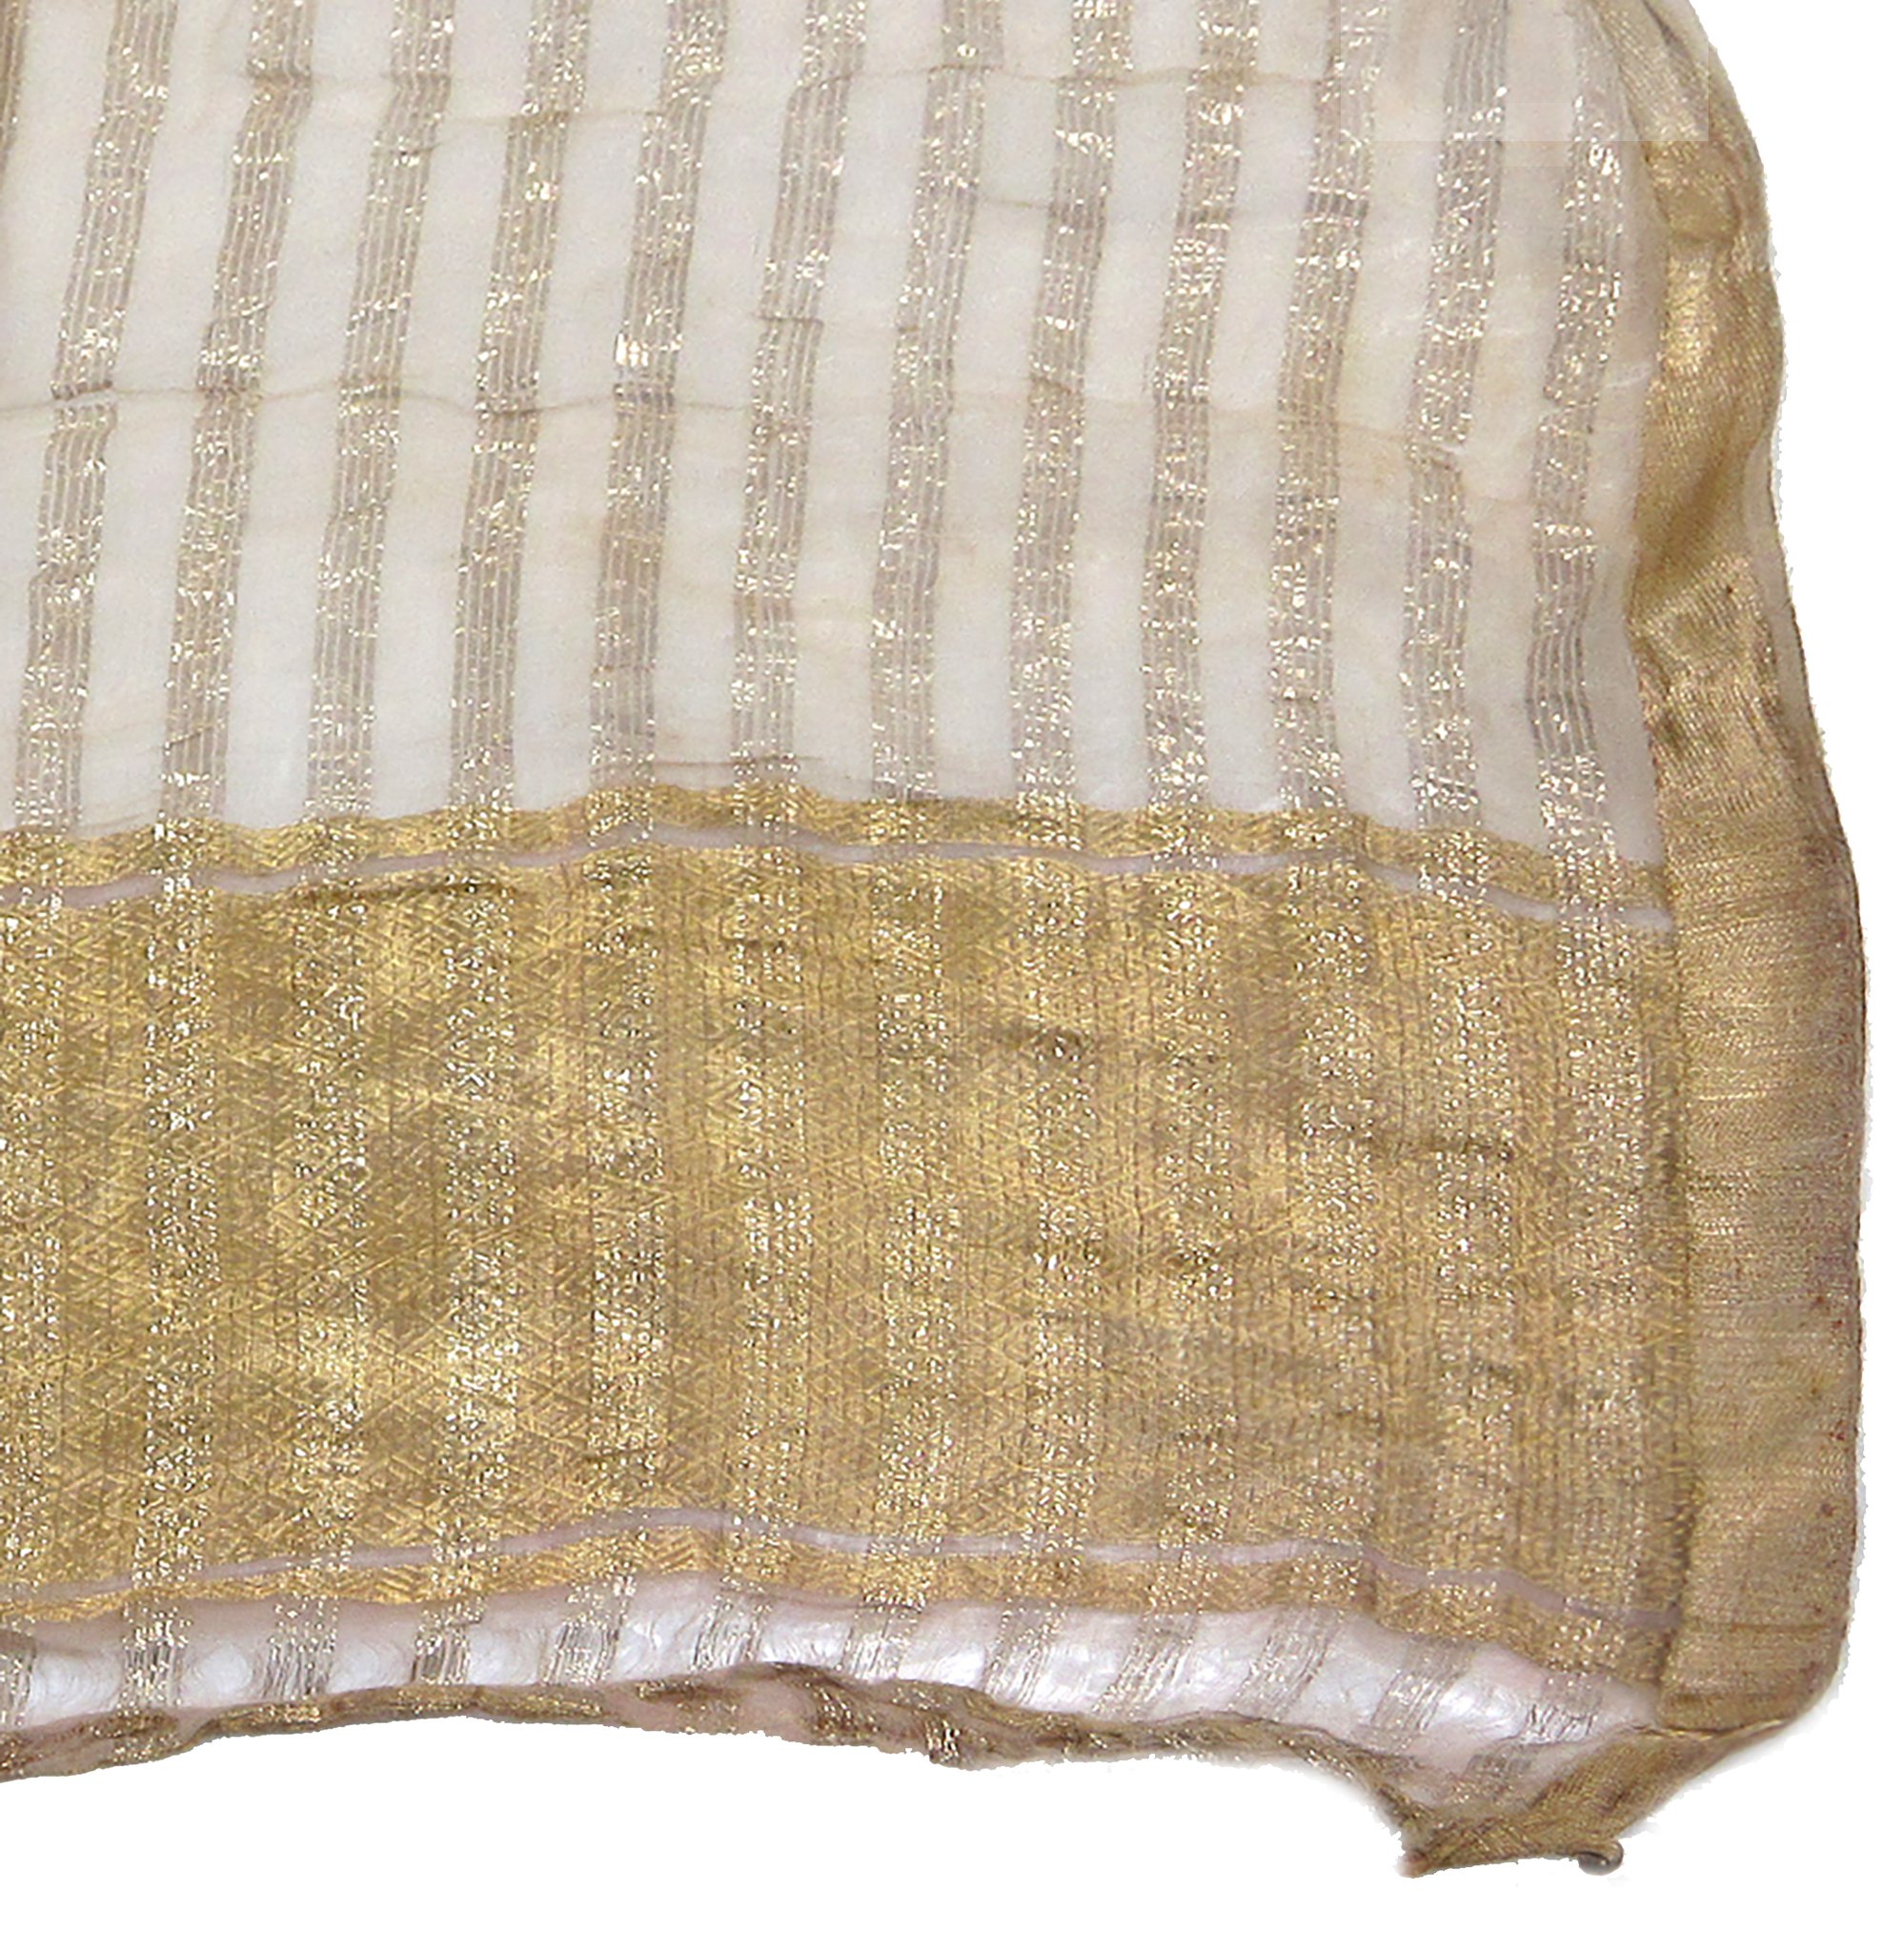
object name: textile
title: Sari-length textile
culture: bangladesh, dacca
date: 1801-1933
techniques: weave